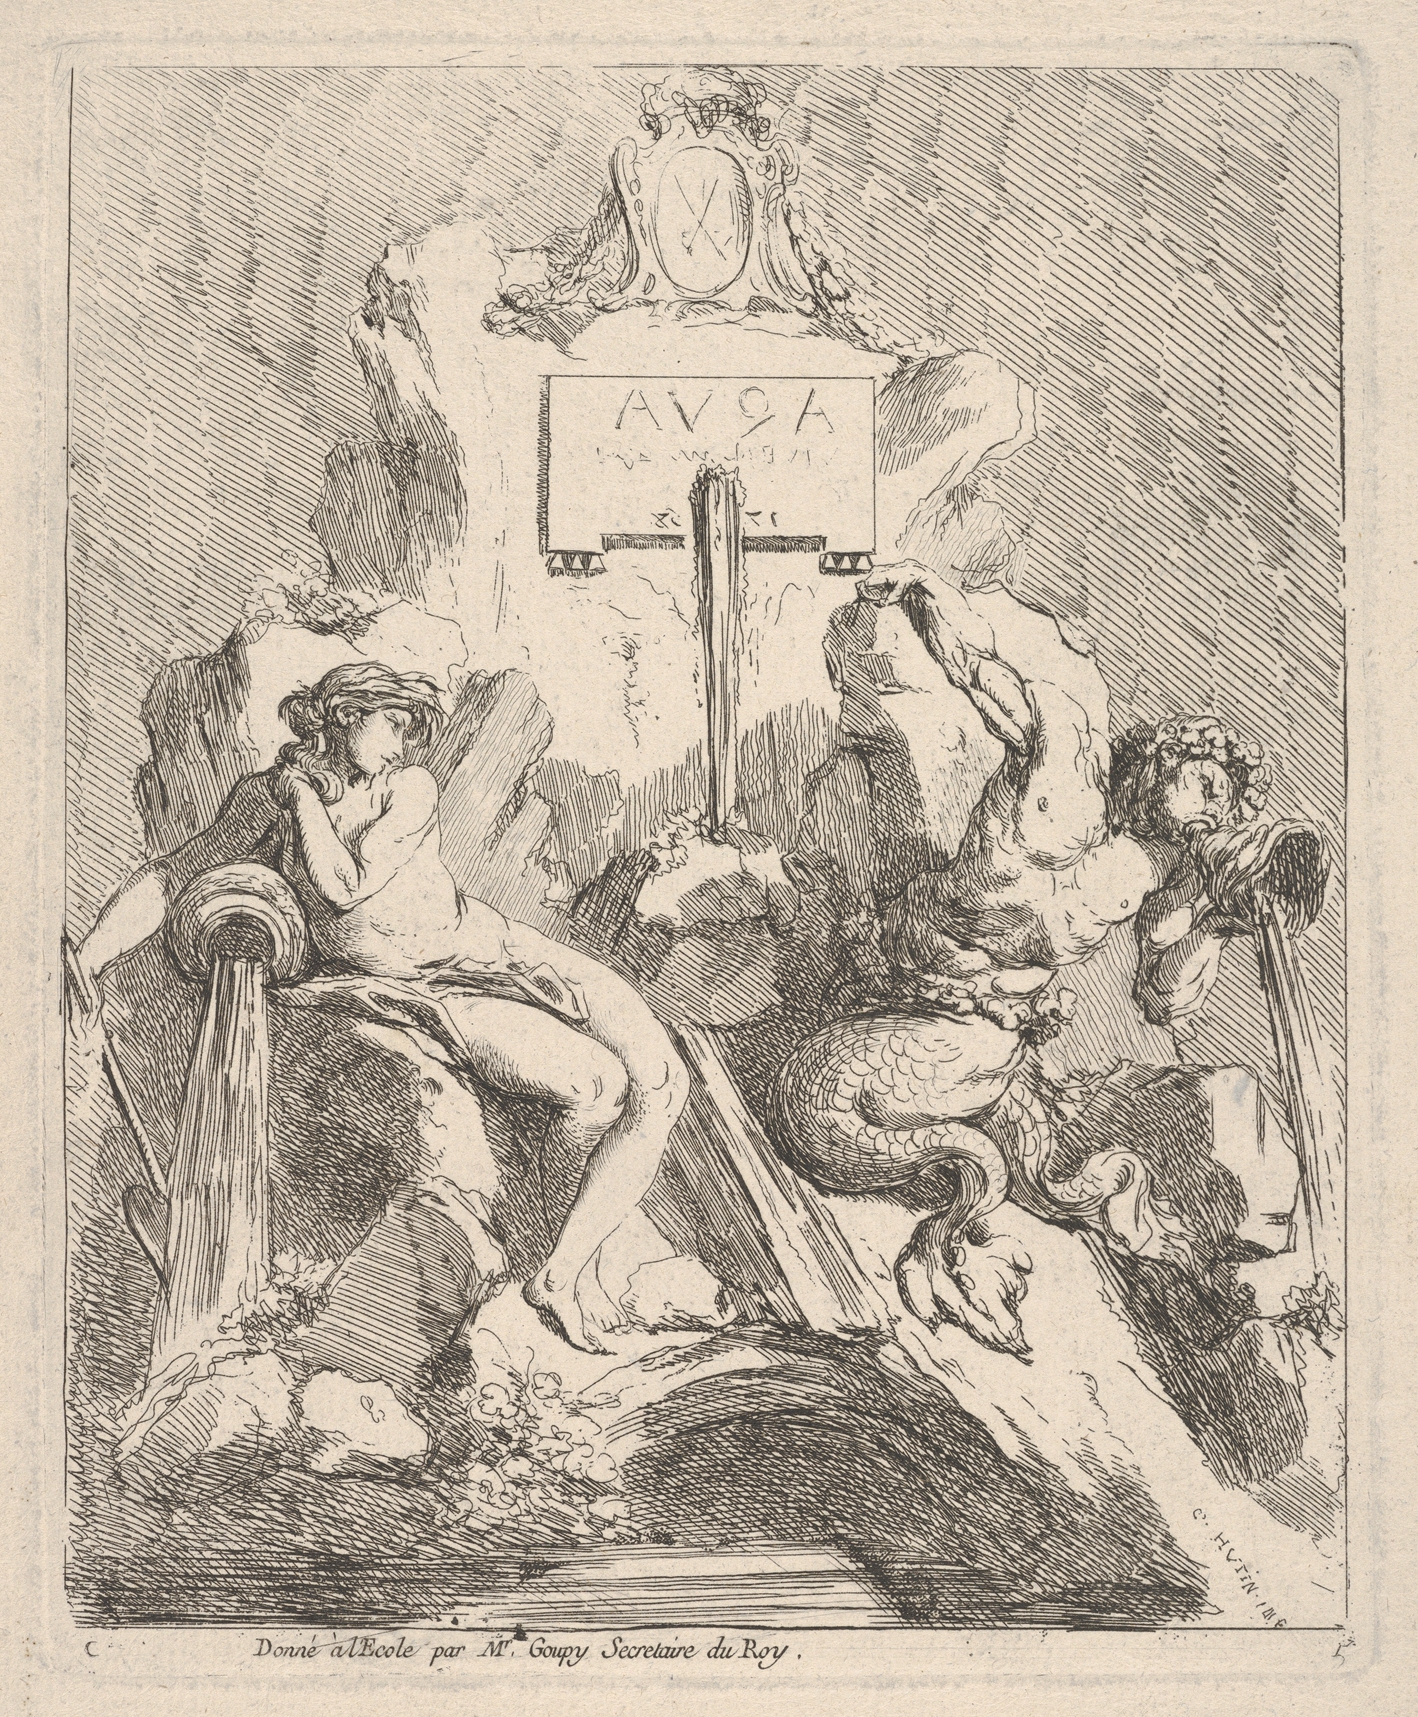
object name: print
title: Design for a fountain with a seated nymph at left and triton holding a shell to his mouth at right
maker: charles françois hutin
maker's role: artist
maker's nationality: french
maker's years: 1715-1776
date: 1768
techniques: etching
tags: fountains,triton,nymphs,shells